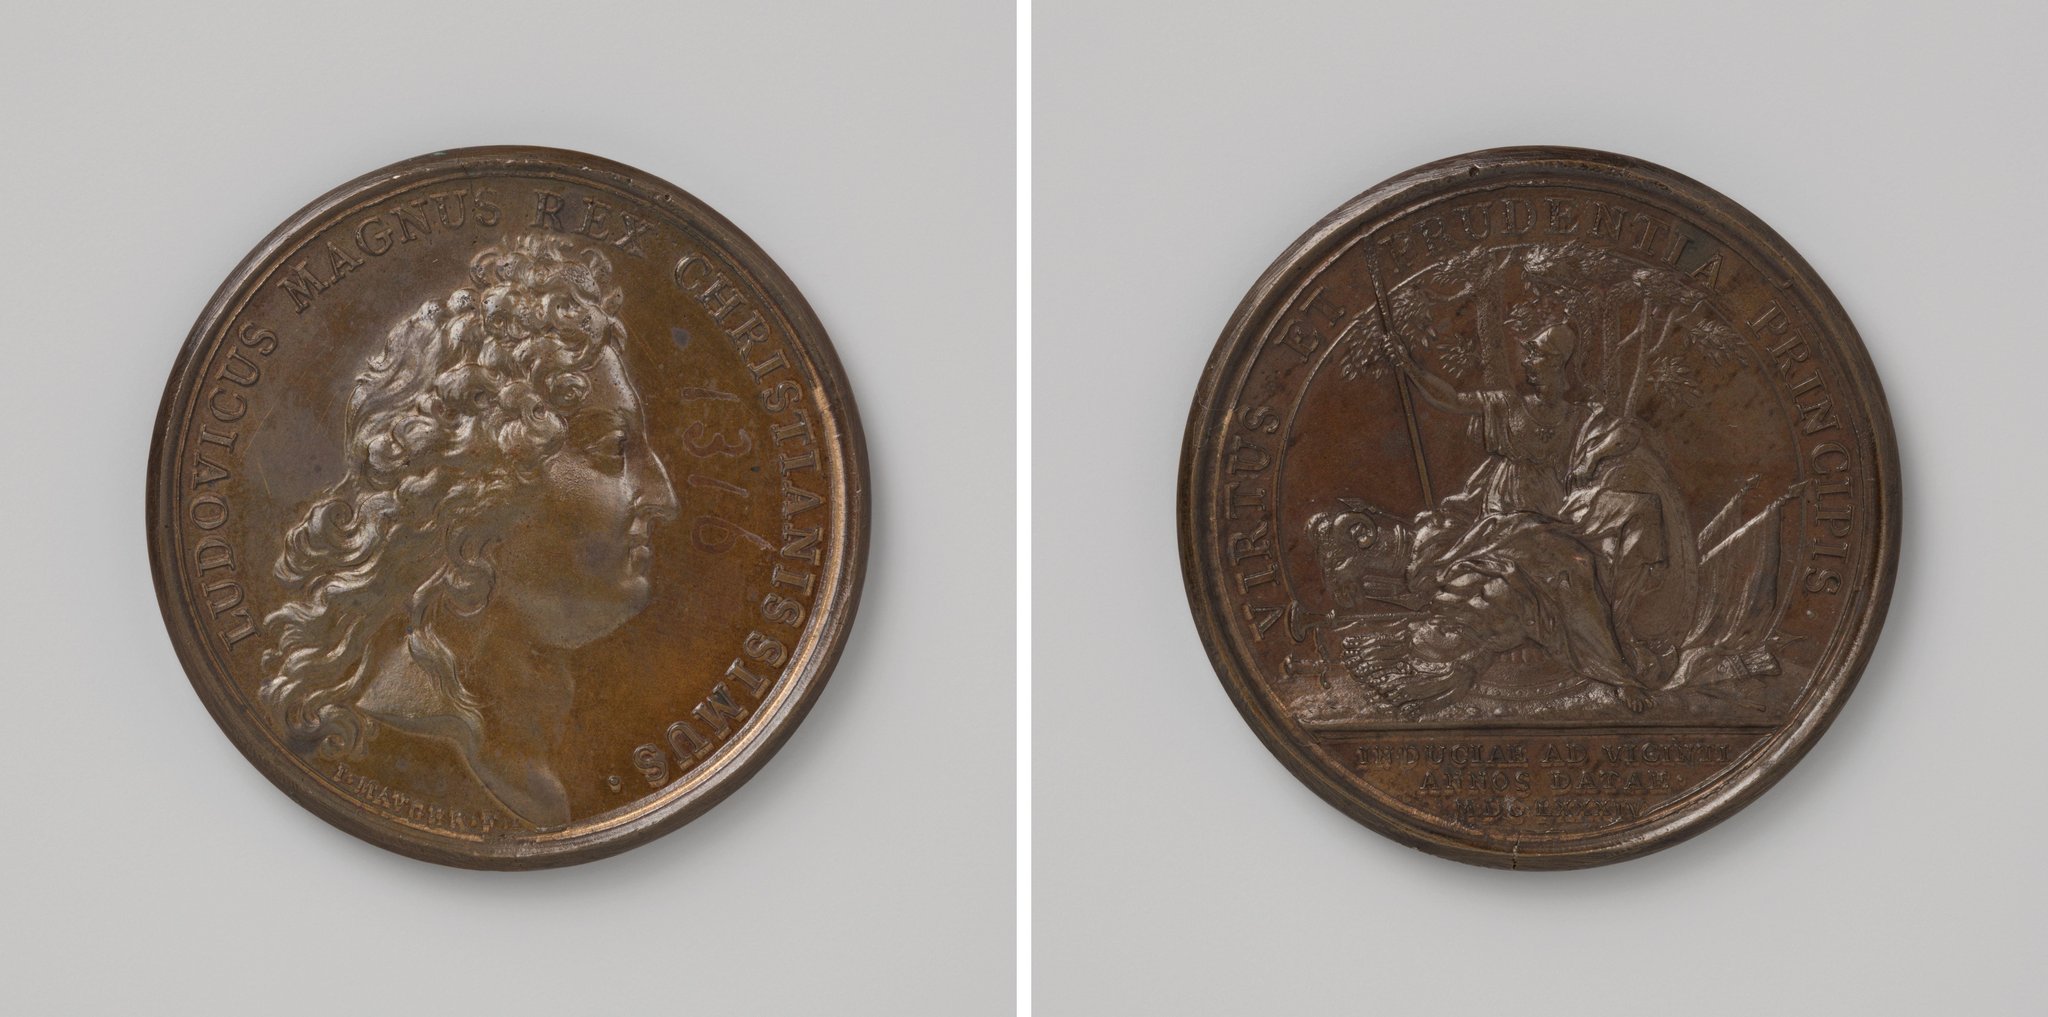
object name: history medal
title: Twintigjarige bestand van Regensburg tussen Frankrijk, de Keizer, Spanje en de Nederlanden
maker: jean mauger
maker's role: medailleur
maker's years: 1648-1722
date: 1699-1703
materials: bronze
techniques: striking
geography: paris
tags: lodewijk xiv (koning van frankrijk)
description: Bronzen penning. Voorzijde: borststuk man binnen omschrift. Keerzijde: Pallas met schild en speer zittend op wapentuig onder laurierboom binnen omschrift; afsnede: opschrift